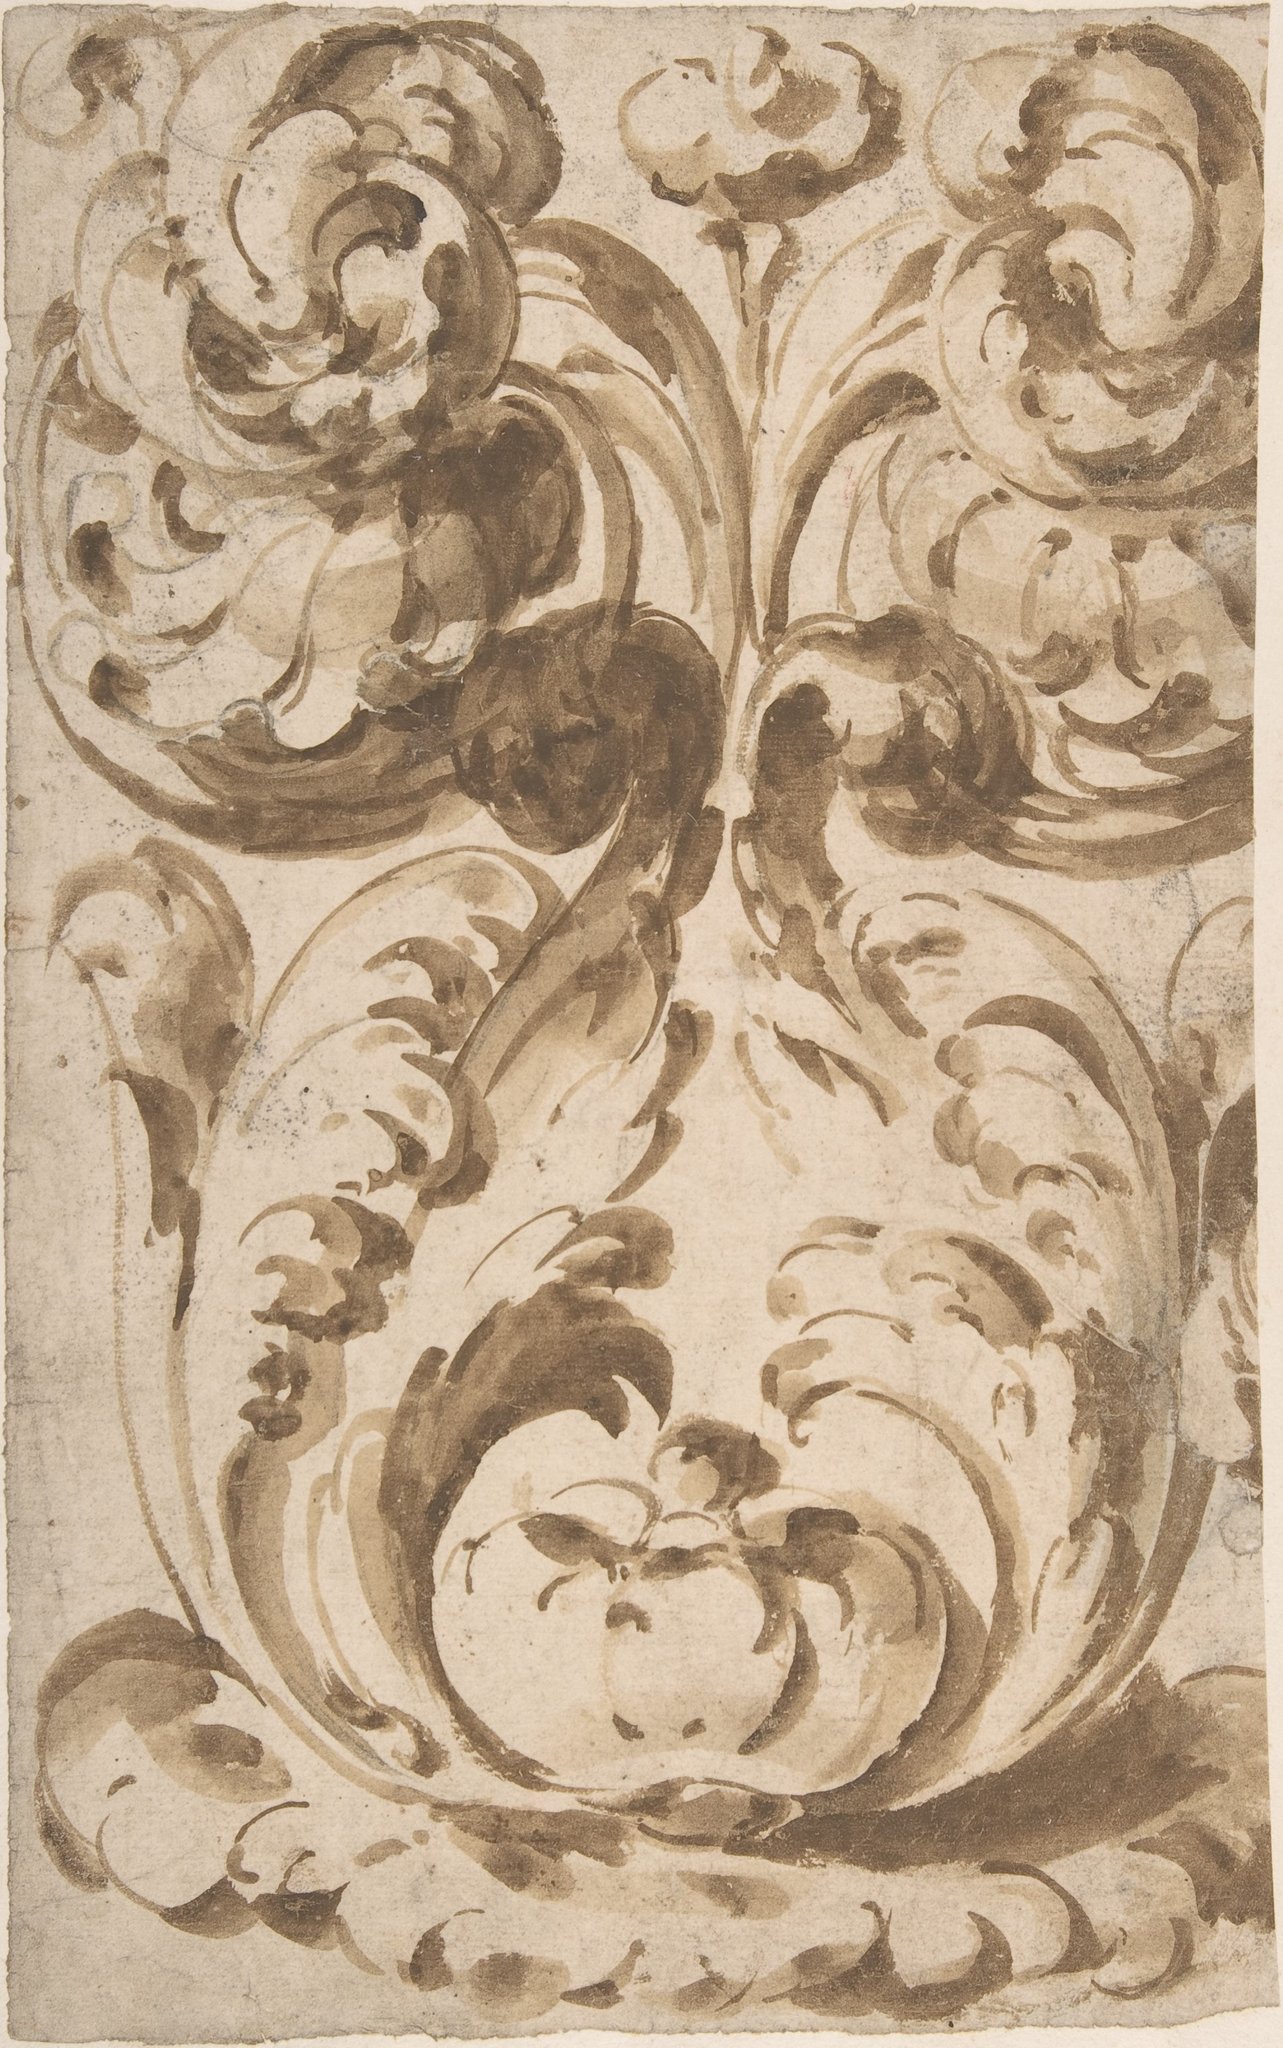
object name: drawing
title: Symmetrical Design of Upward Growing Acanthus Scrolls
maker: anonymous, italian, 17th century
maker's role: artist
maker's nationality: italian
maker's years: 1600-1700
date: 1601-1700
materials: graphite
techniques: brush, wash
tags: acanthus,leaves